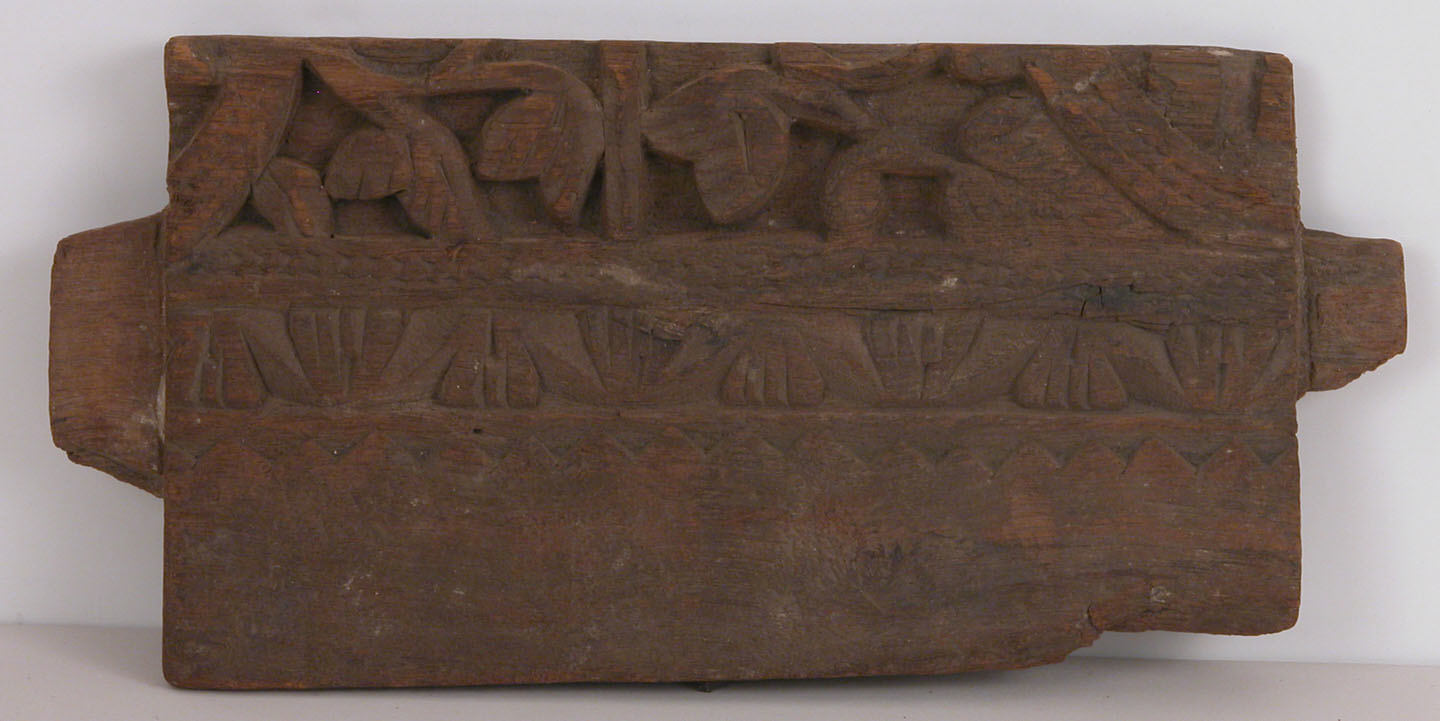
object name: panel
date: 701-900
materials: wood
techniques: carving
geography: iraq